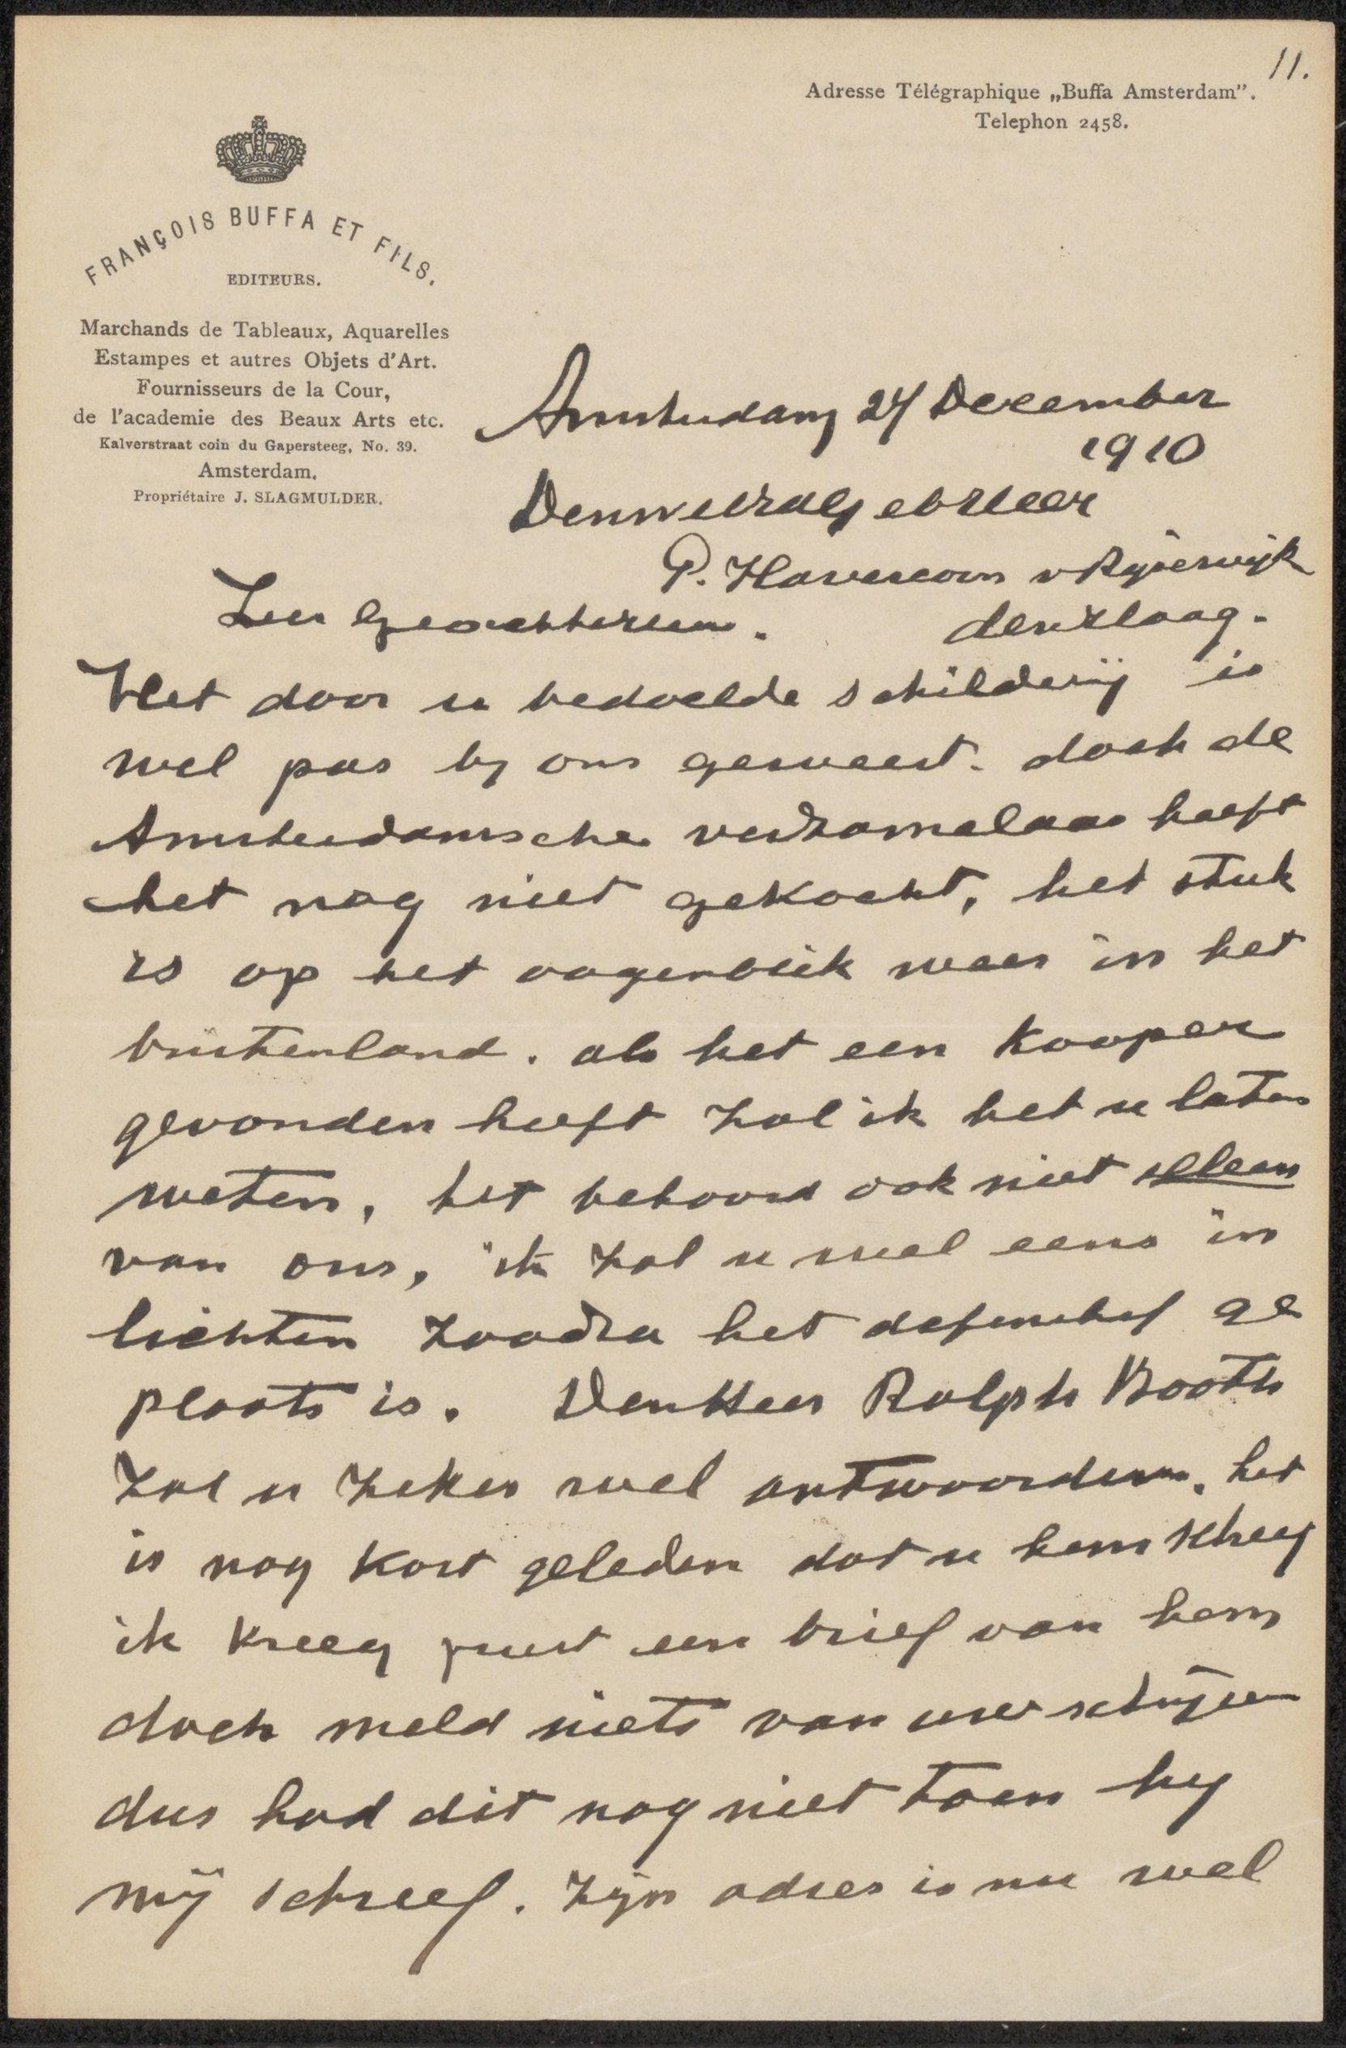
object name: letter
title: Brief aan Pieter Haverkorn van Rijsewijk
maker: jacobus slagmulder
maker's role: kunsthandelaar, kunstverzamelaar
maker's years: 1860-1921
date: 1910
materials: ink, paper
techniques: pen, printing, writing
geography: amsterdam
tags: the hague, london, painter, print maker, draughtsman, matthijs maris, pieter haverkorn van rijsewijk, elbert jan van wisselingh, art trade, art shop, painting (including book-illumination, miniature-painting)